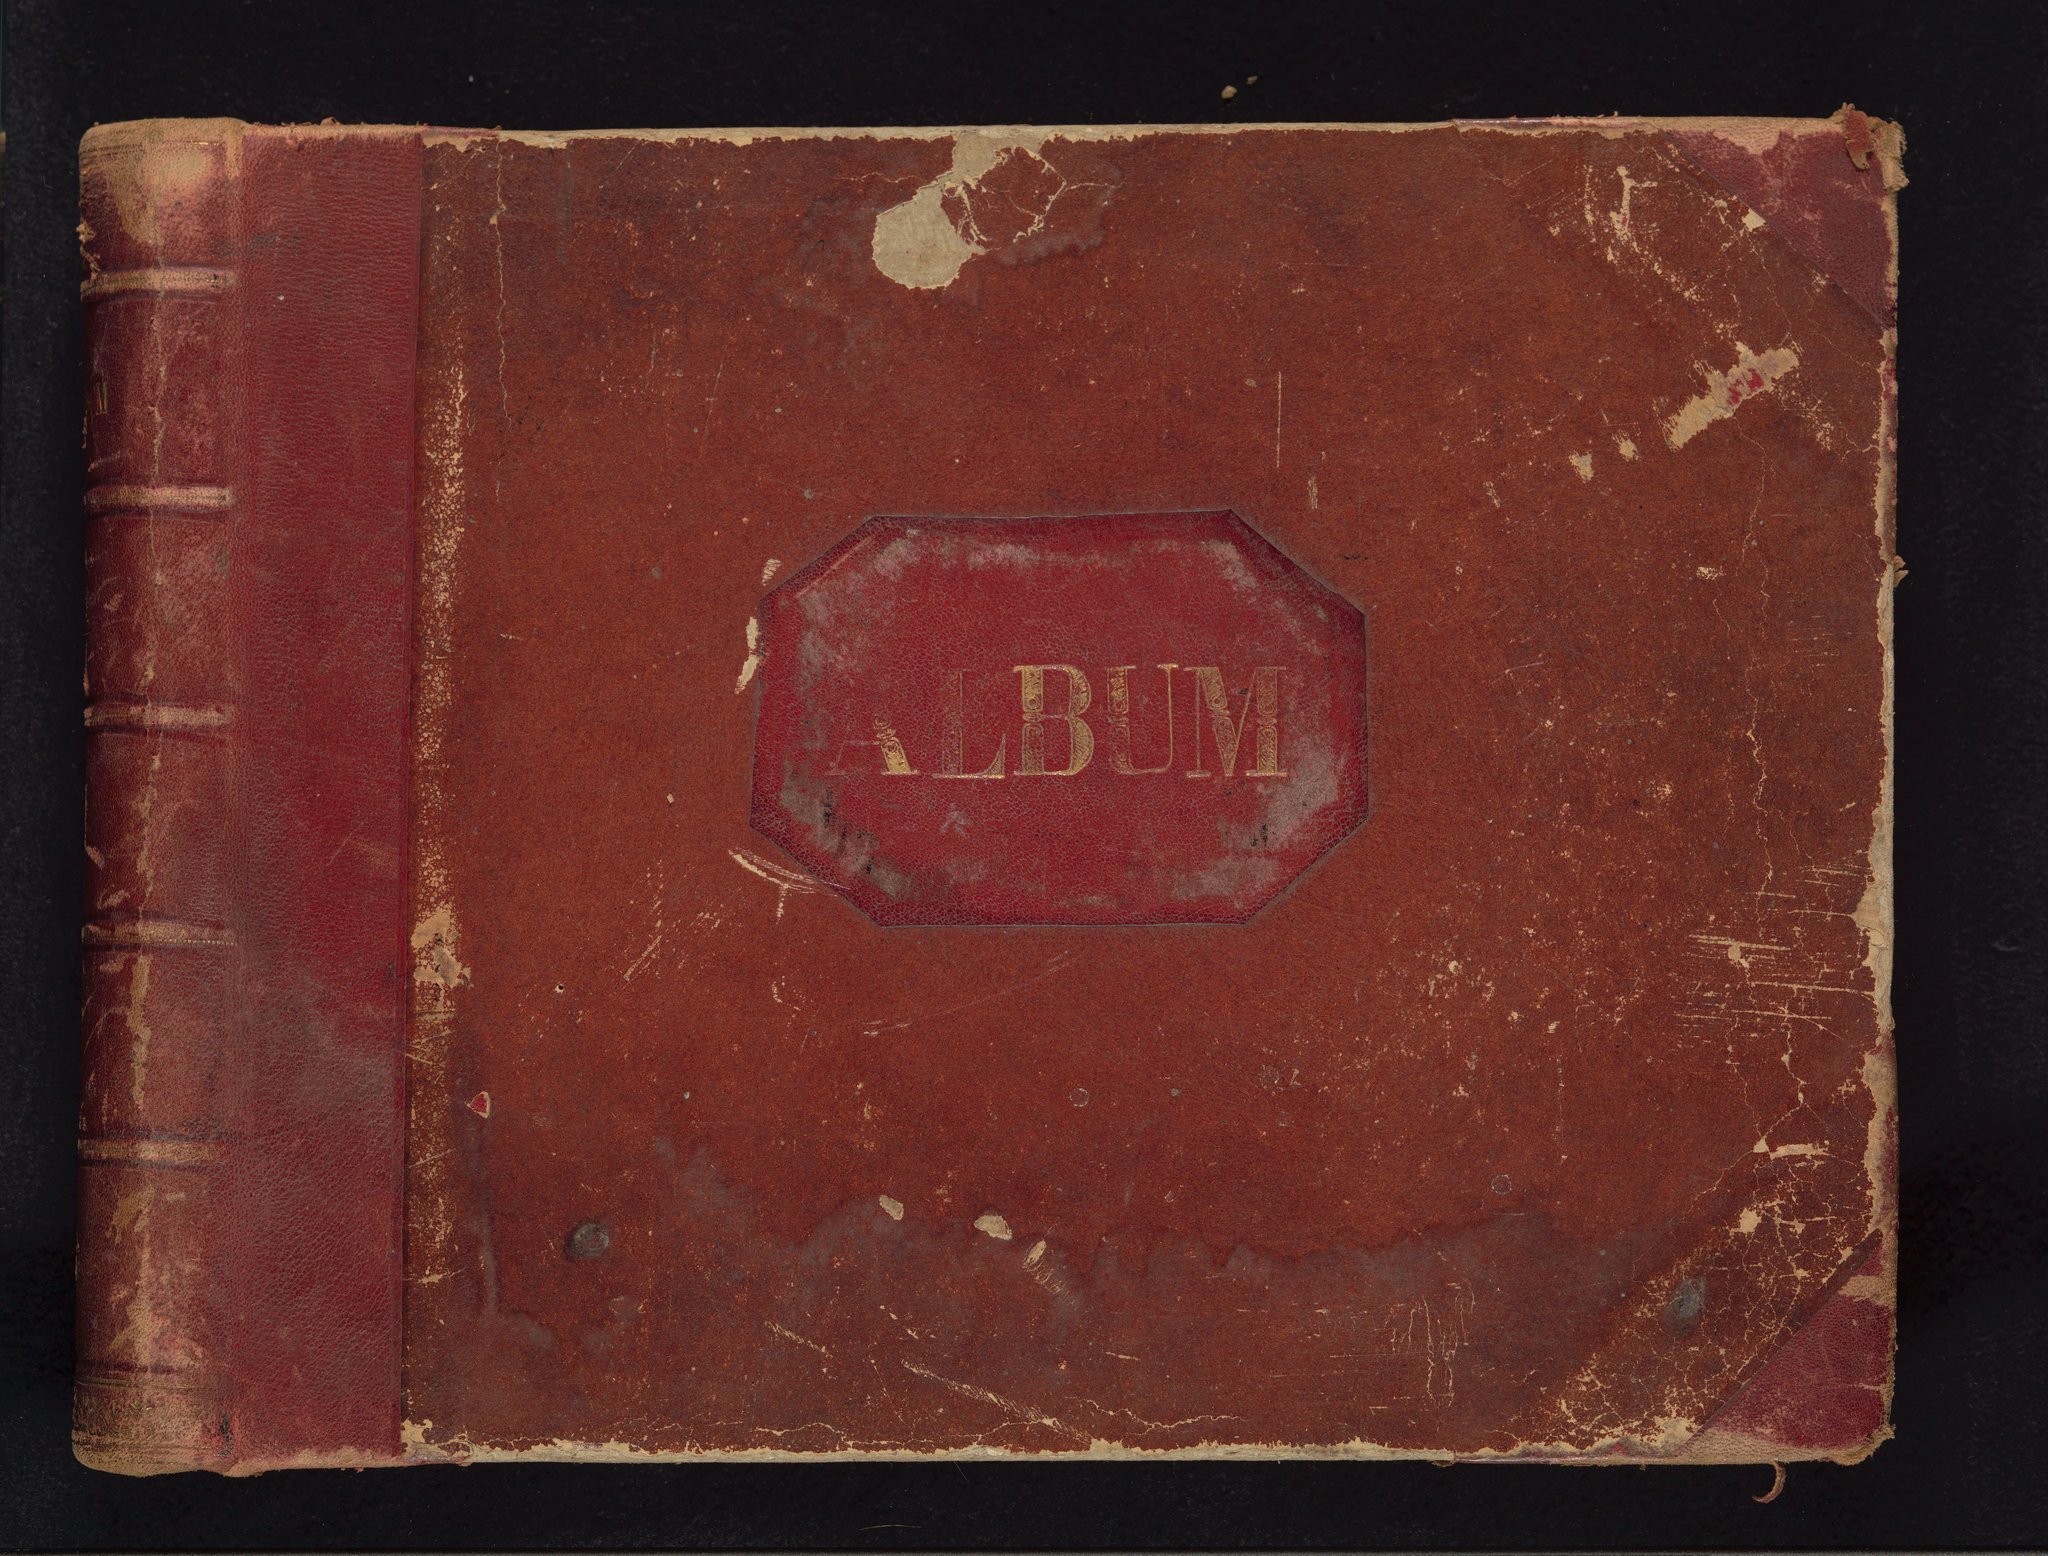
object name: photograph album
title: [Imagerie Franklin]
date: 1876-1880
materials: cardboard, leather, linen, paper, photographic support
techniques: albumen print, photograph, combed marbled paper, printing, woodburytype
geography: liège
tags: city-view in general; 'veduta', historical persons, ranks ~ rulers, sovereigns, paris, belgium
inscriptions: date: ‘SEPT/ 1986’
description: Opnames van reproducties van schilderijen, prenten en tekeningen door onder andere Louis Gallait, Charles Soubre, Joseph Barthélémy Vieillevoye en Gérard de Lairesse en portretten en reproducties van geschilderde en getekende portretten van onder andere Leopold I van België, Rudolf van Oostenrijk en Stefanie van België. Daarnaast enkele gezichten op pleinen en gebouwen in Belgische steden en een façade in Belgische stijl op de wereldtentoonstelling van Parijs in 1878. Achterin het album is op een afwijkende pagina een portret toegevoegd van de eigenaar van het boek met twee collega's.